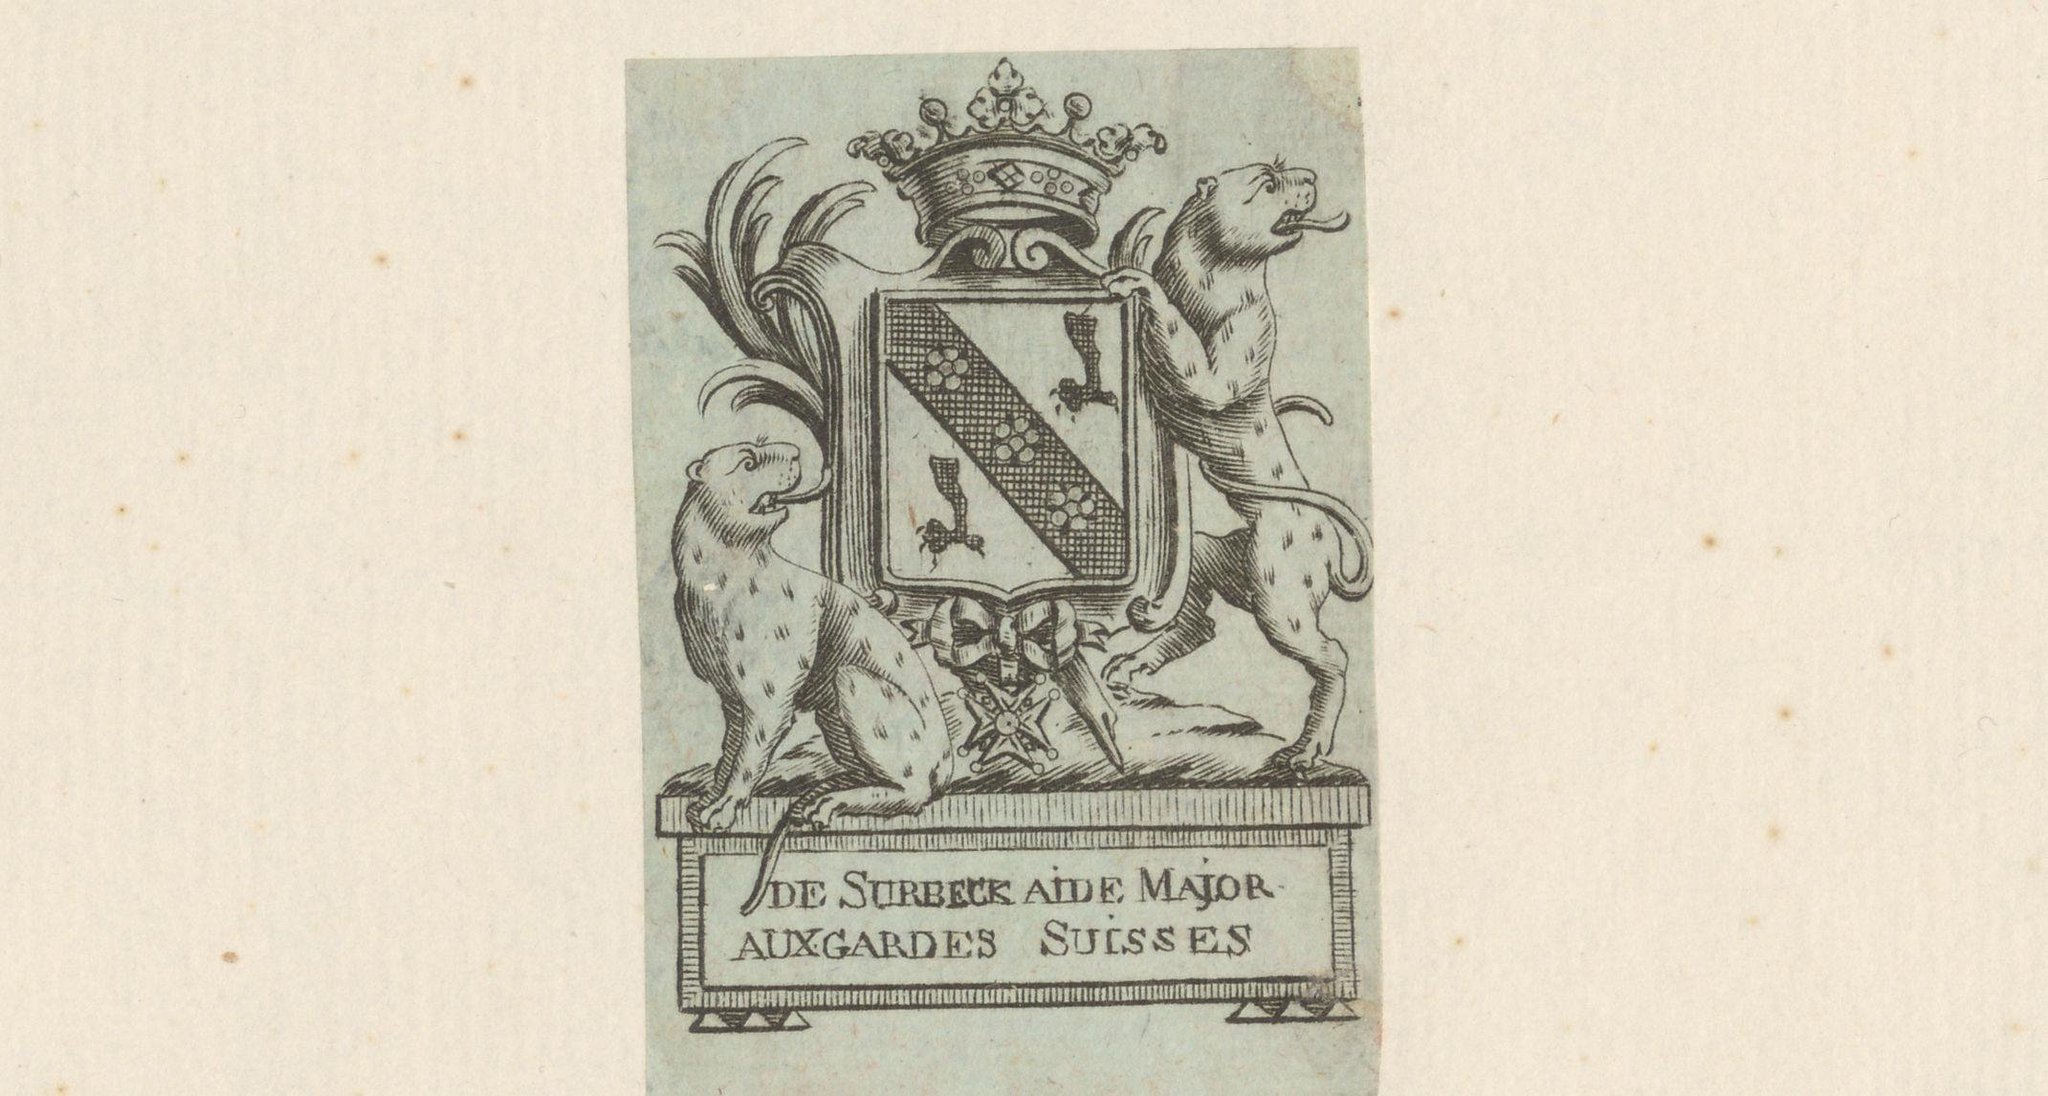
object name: bookplate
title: Ex libris van De Surbeck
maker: Anonymous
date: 1763-1840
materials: paper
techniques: engraving, etching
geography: switzerland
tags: beasts of prey, predatory animals: panther, armorial bearing, heraldry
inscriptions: collector's mark: Lugt 2760, inscription: ‘2227’, collector's mark: Lugt 2233